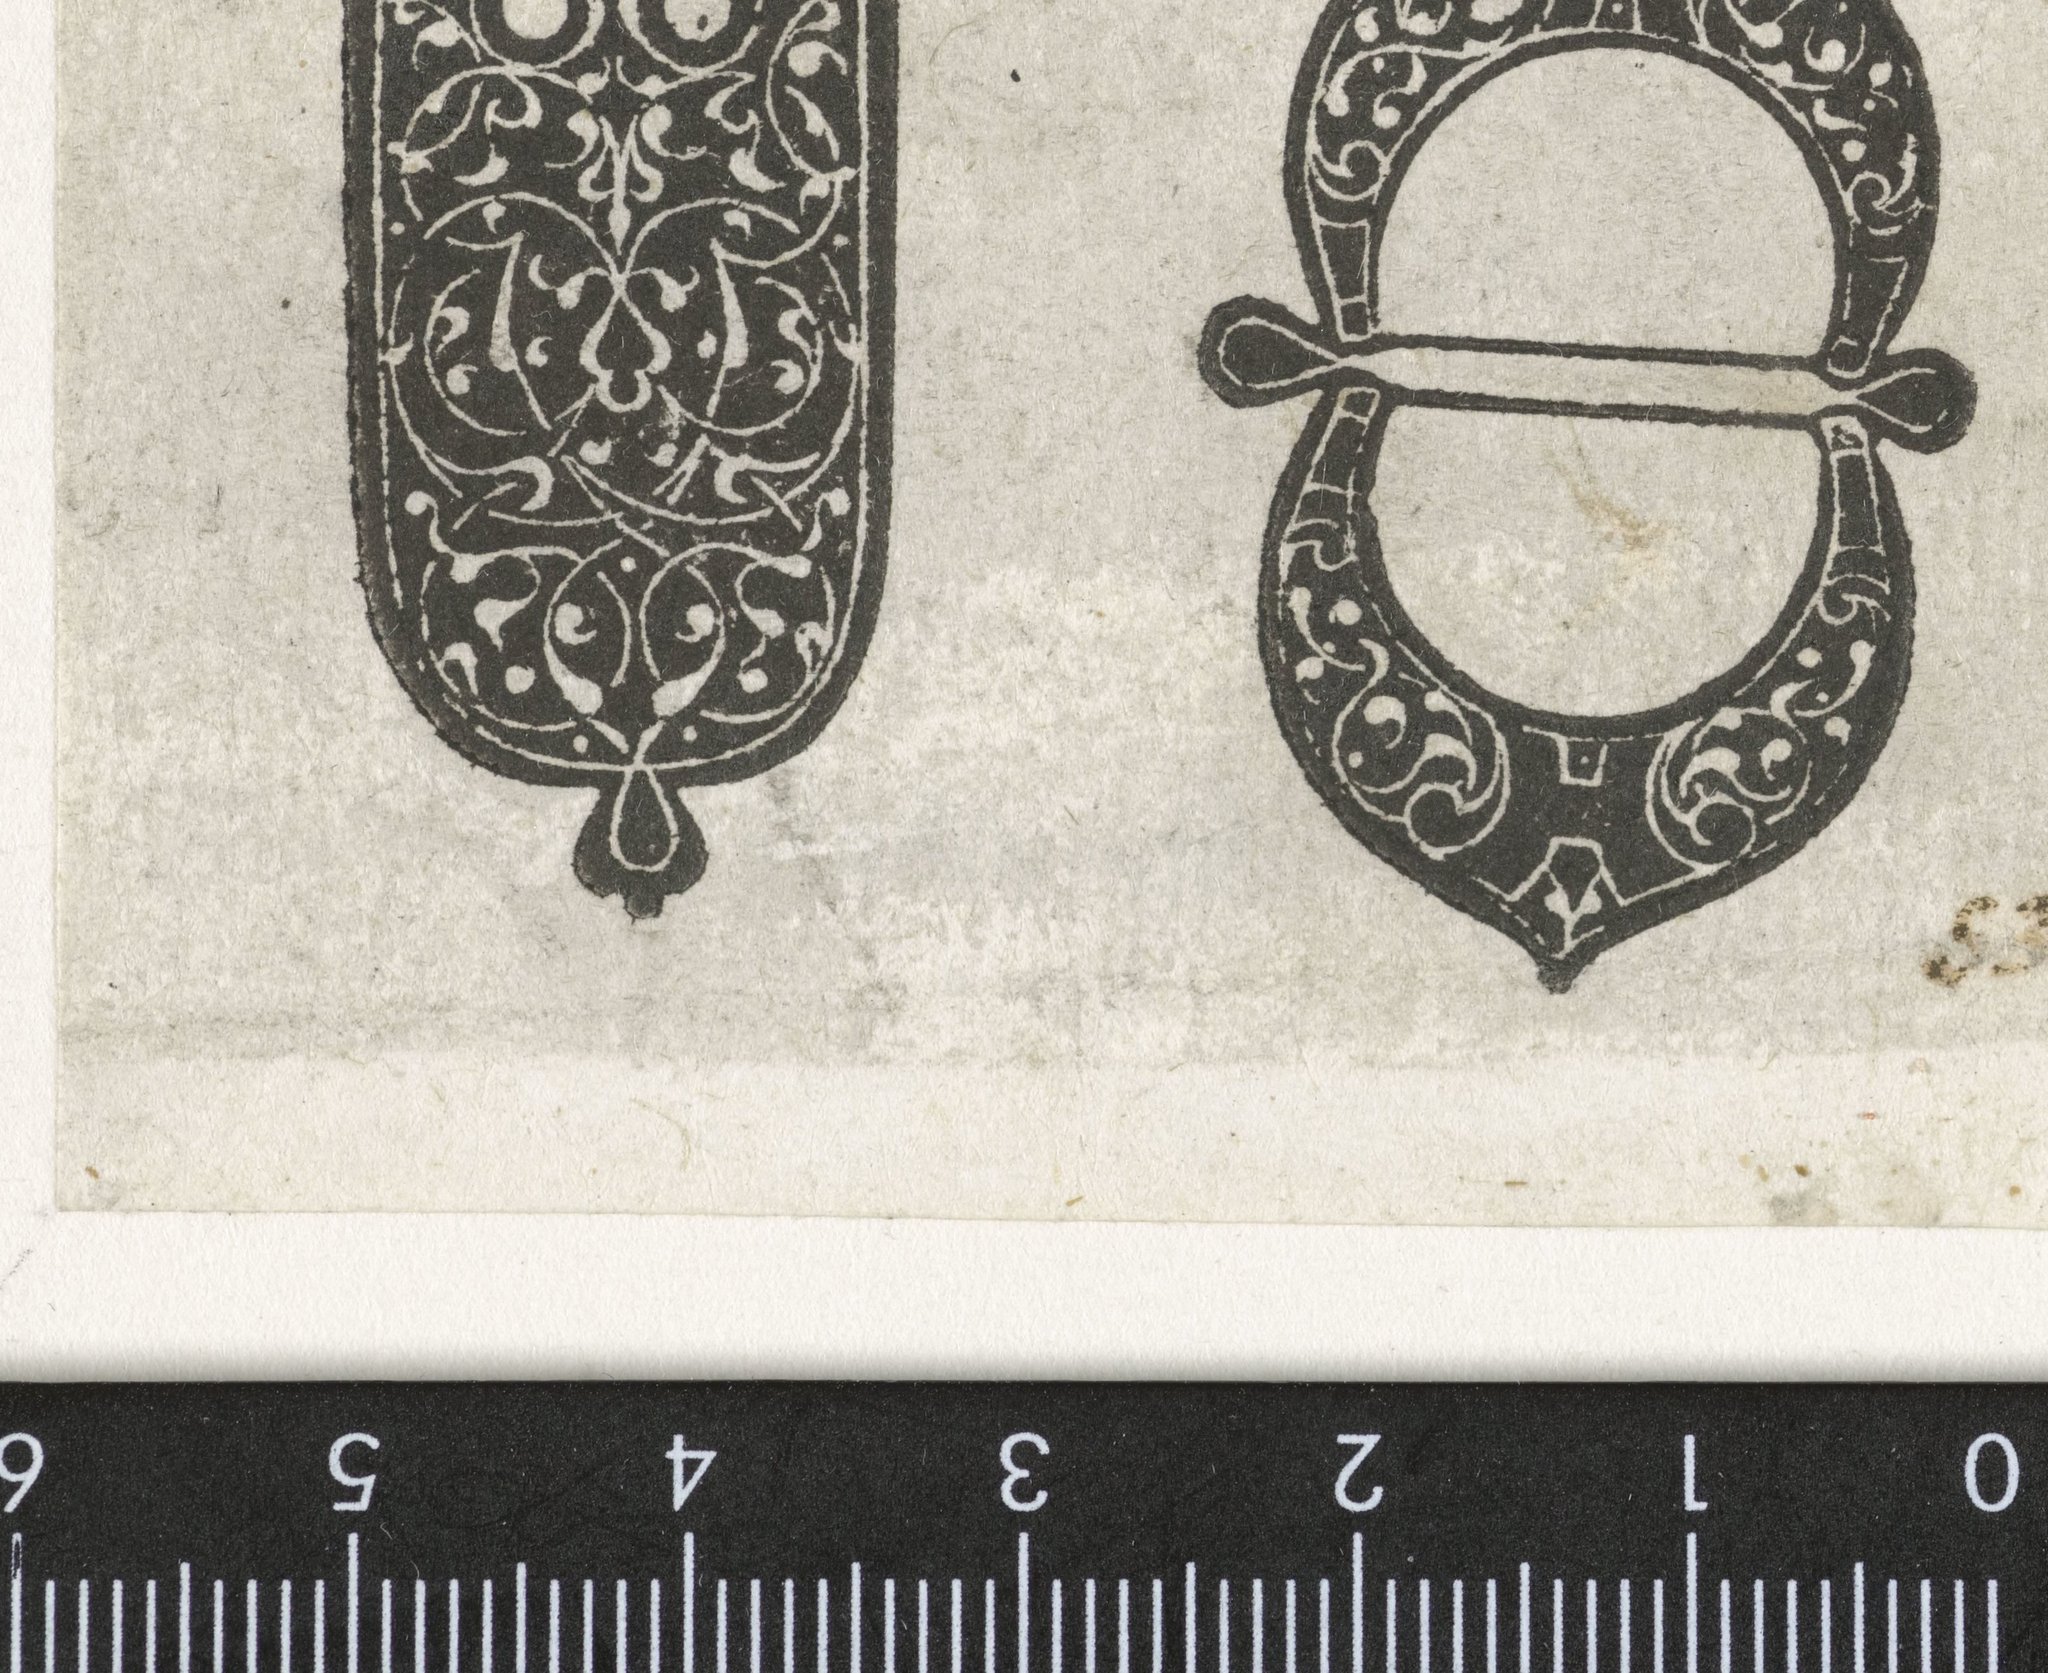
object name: print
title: Kostuumornamenten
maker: Anonymous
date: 1516-1571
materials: paper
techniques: woodcut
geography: france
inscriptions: inscription: ‘538.’